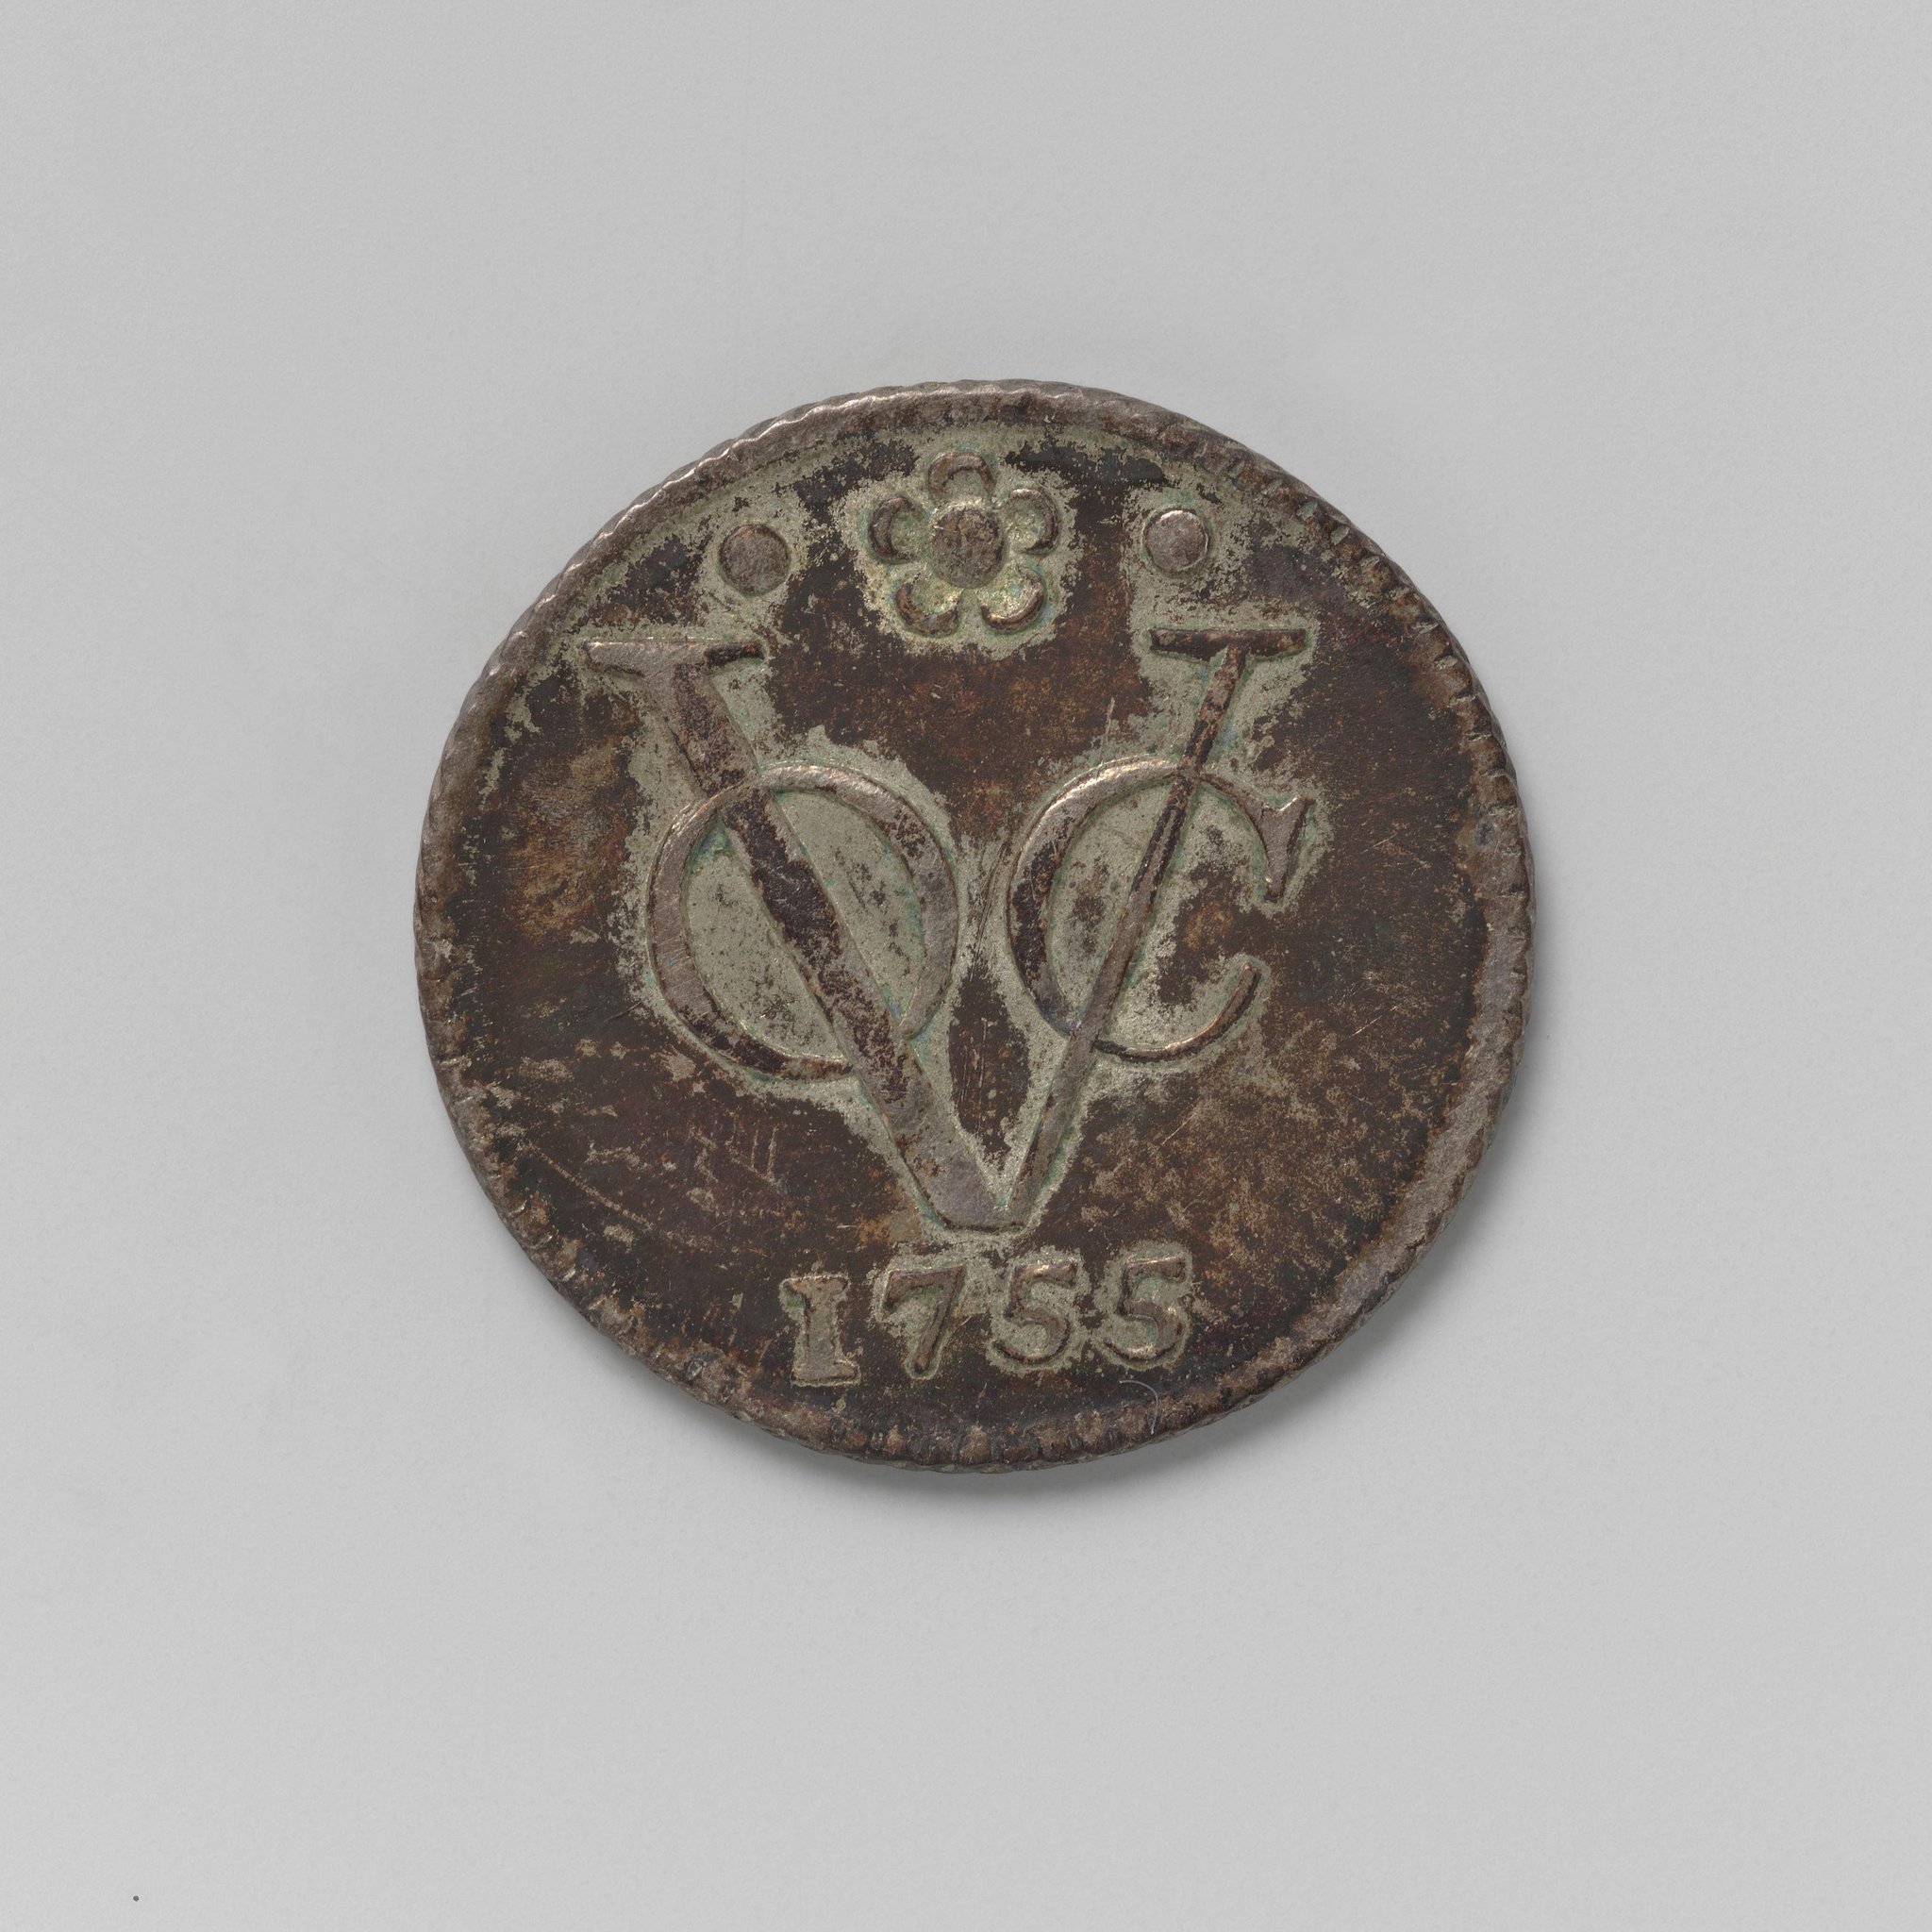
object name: coin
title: Zilveren afslag van een ½ duit van de VOC uit Holland, 1755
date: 1755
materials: silver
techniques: striking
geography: dordrecht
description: Zilveren munt. Voorzijde: gekroond wapenschild van Holland. Keerzijde: monogram van de VOC, waarboven muntteken en waaronder jaartal. Kabelrand.